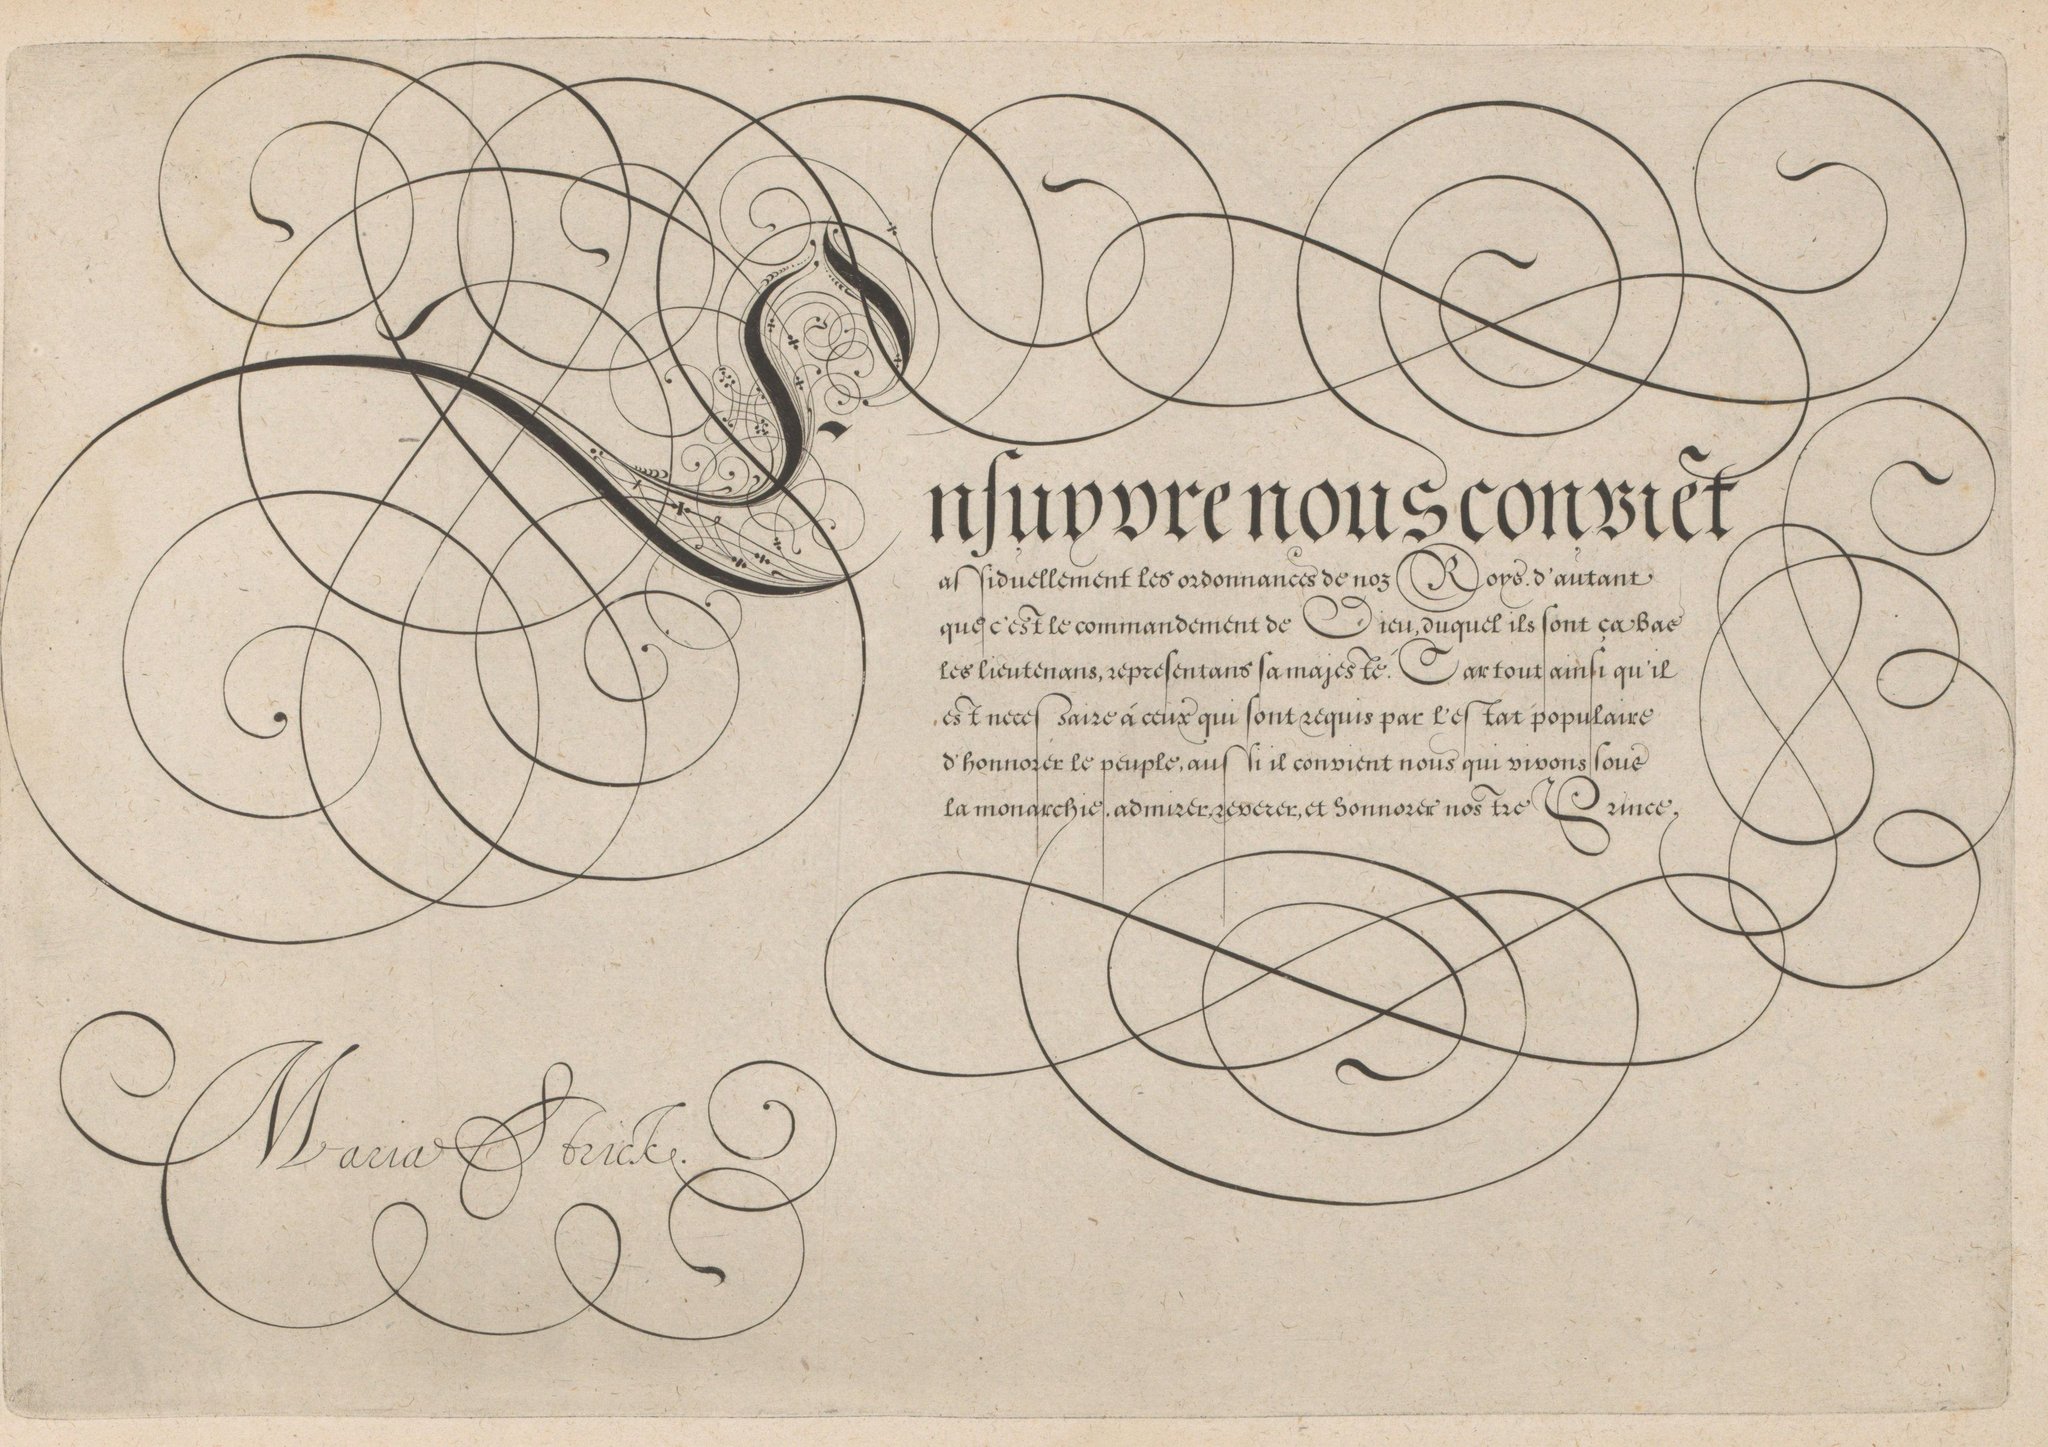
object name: album leaf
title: Schrijfvoorbeeld met kapitaal E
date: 1618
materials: paper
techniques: engraving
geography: rotterdam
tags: calligraphy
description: Schrijfvoorbeeld in het Frans met kapitaal E en zeven regels tekst: Ensuyvre nous (...). Omlijst door kalligrafisch krulwerk. De prent maakt deel uit van een album.